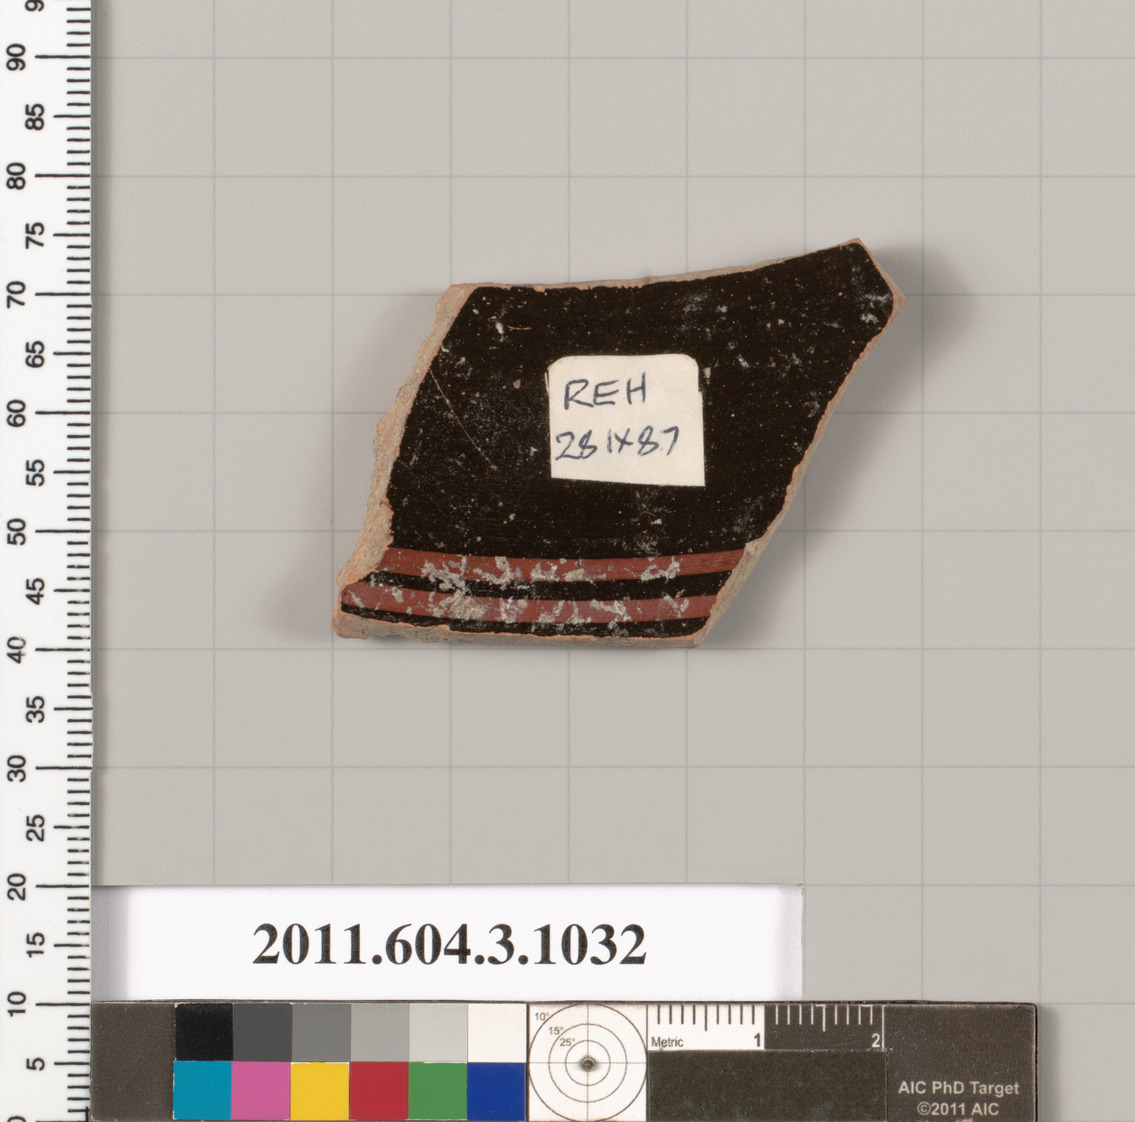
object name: plate fragment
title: Terracotta fragment of a plate?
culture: greek, attic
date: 600-501 BCE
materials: terracotta